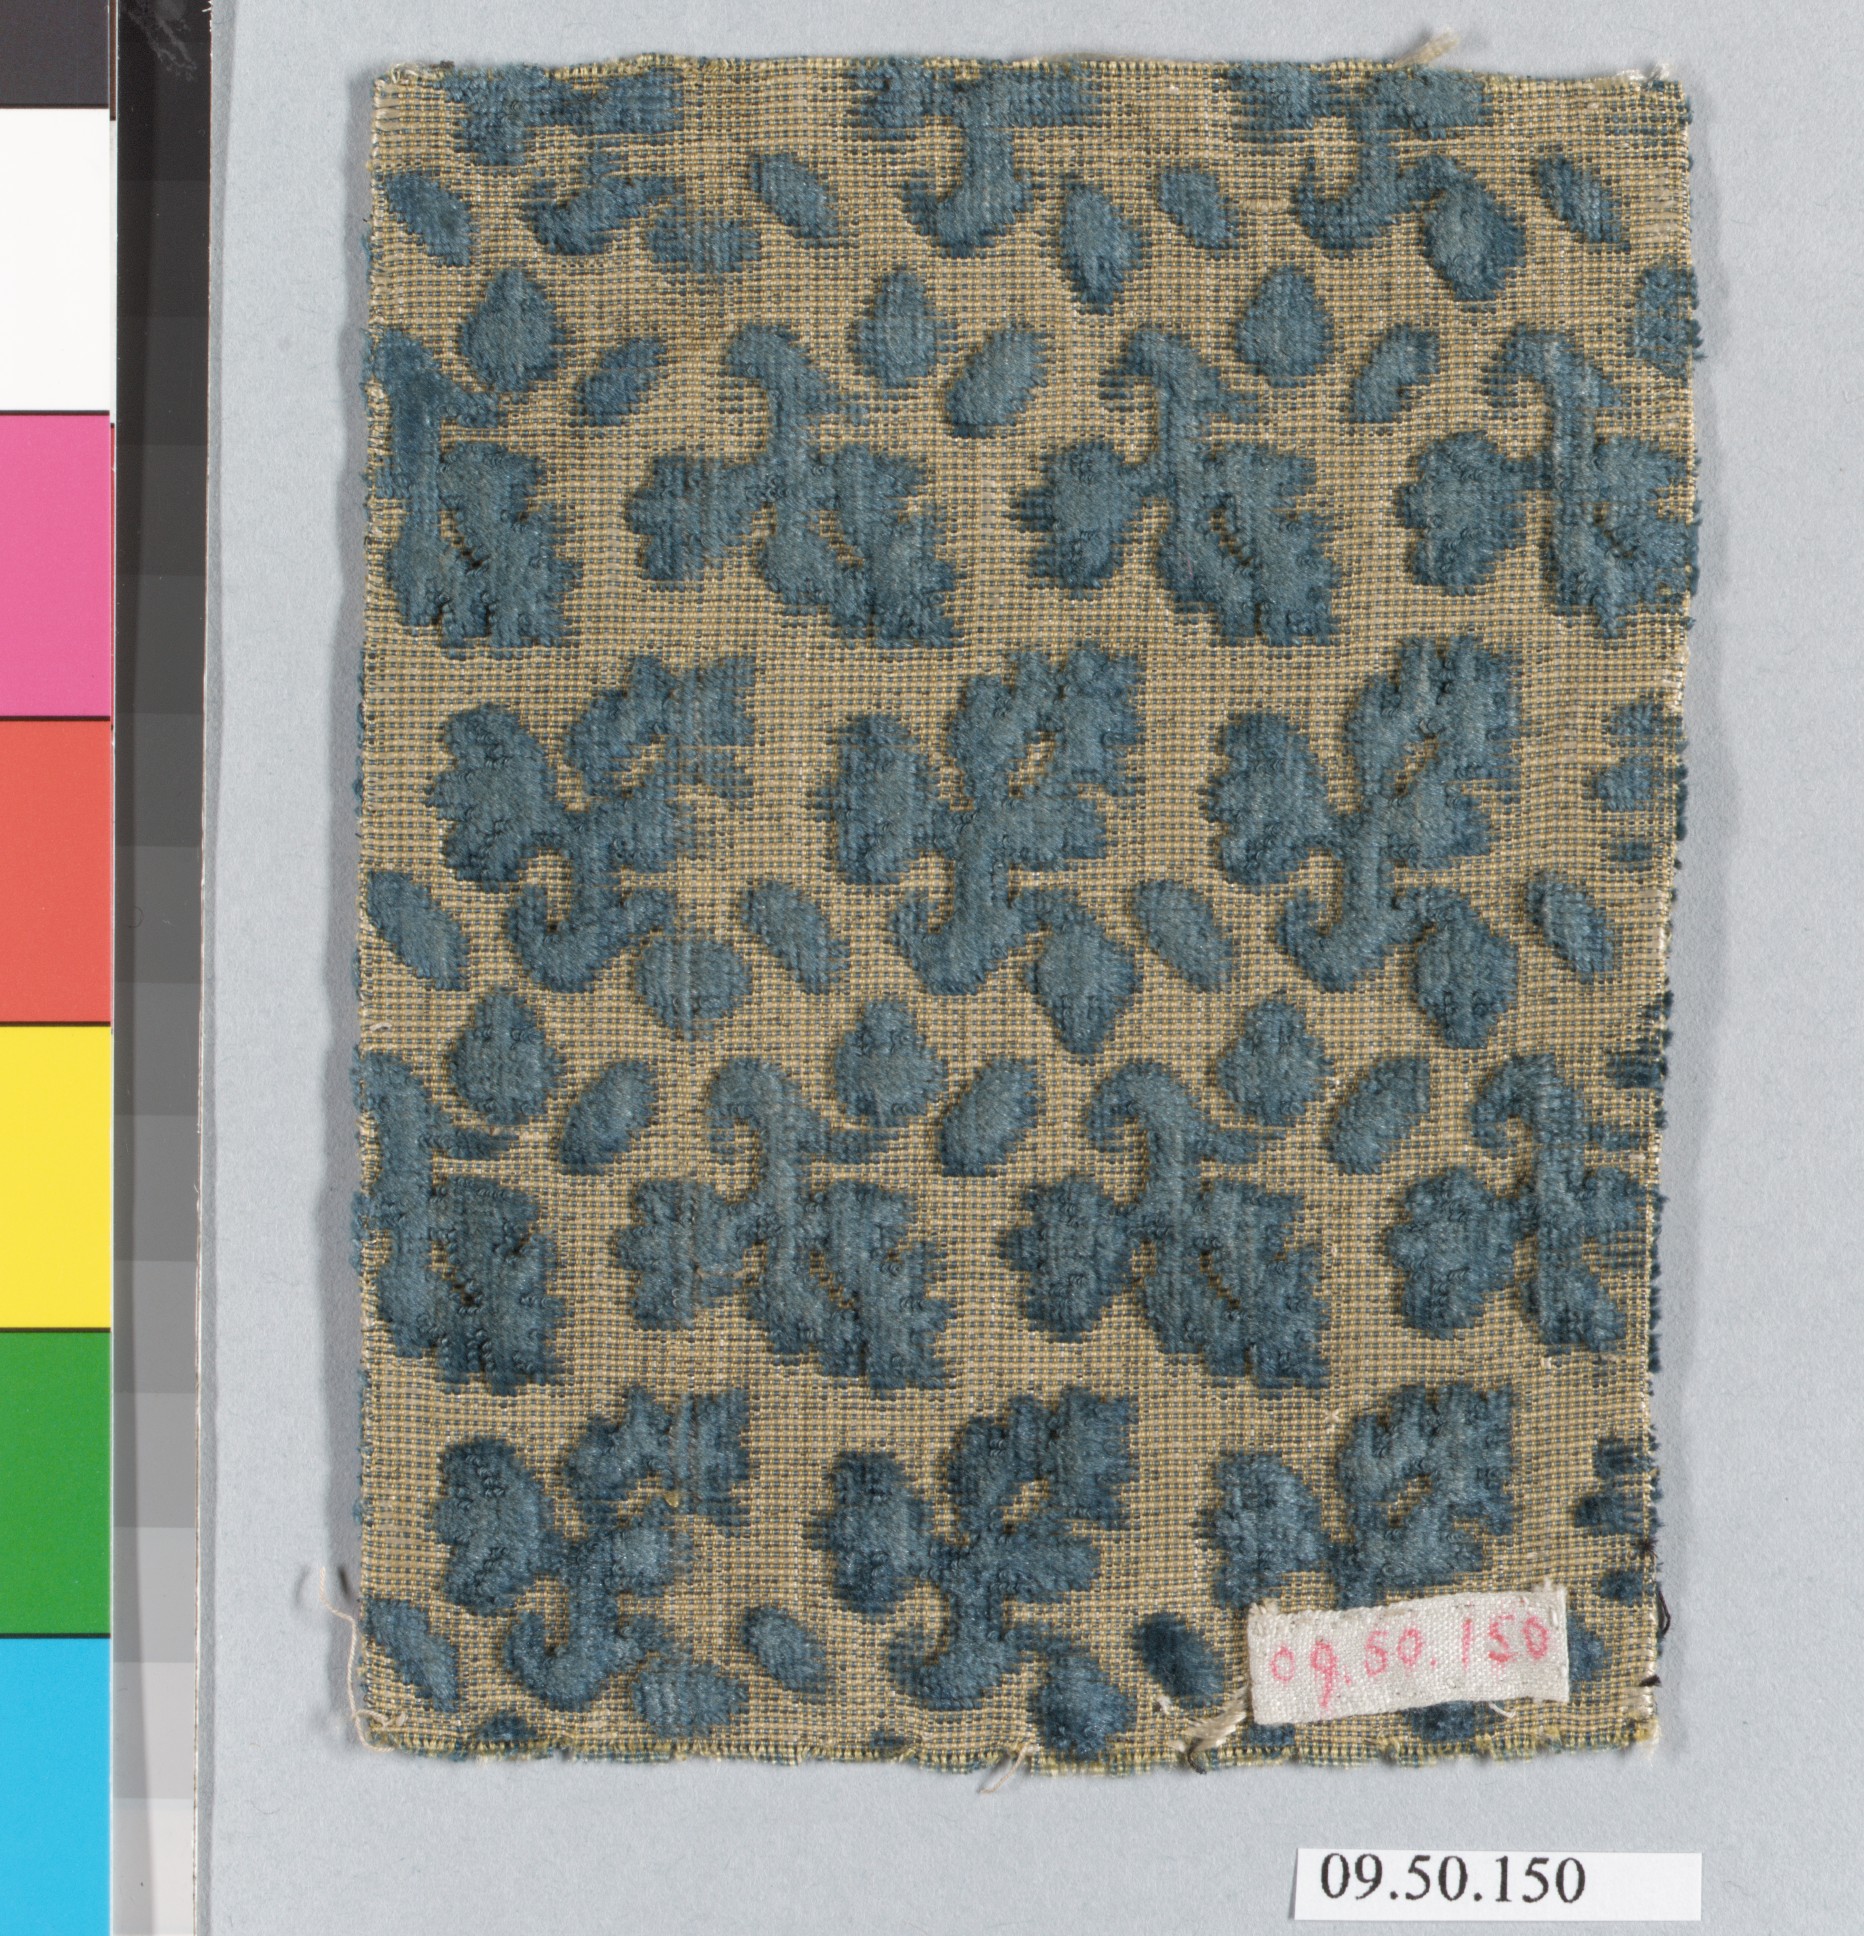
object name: piece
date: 1501-1700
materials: silk